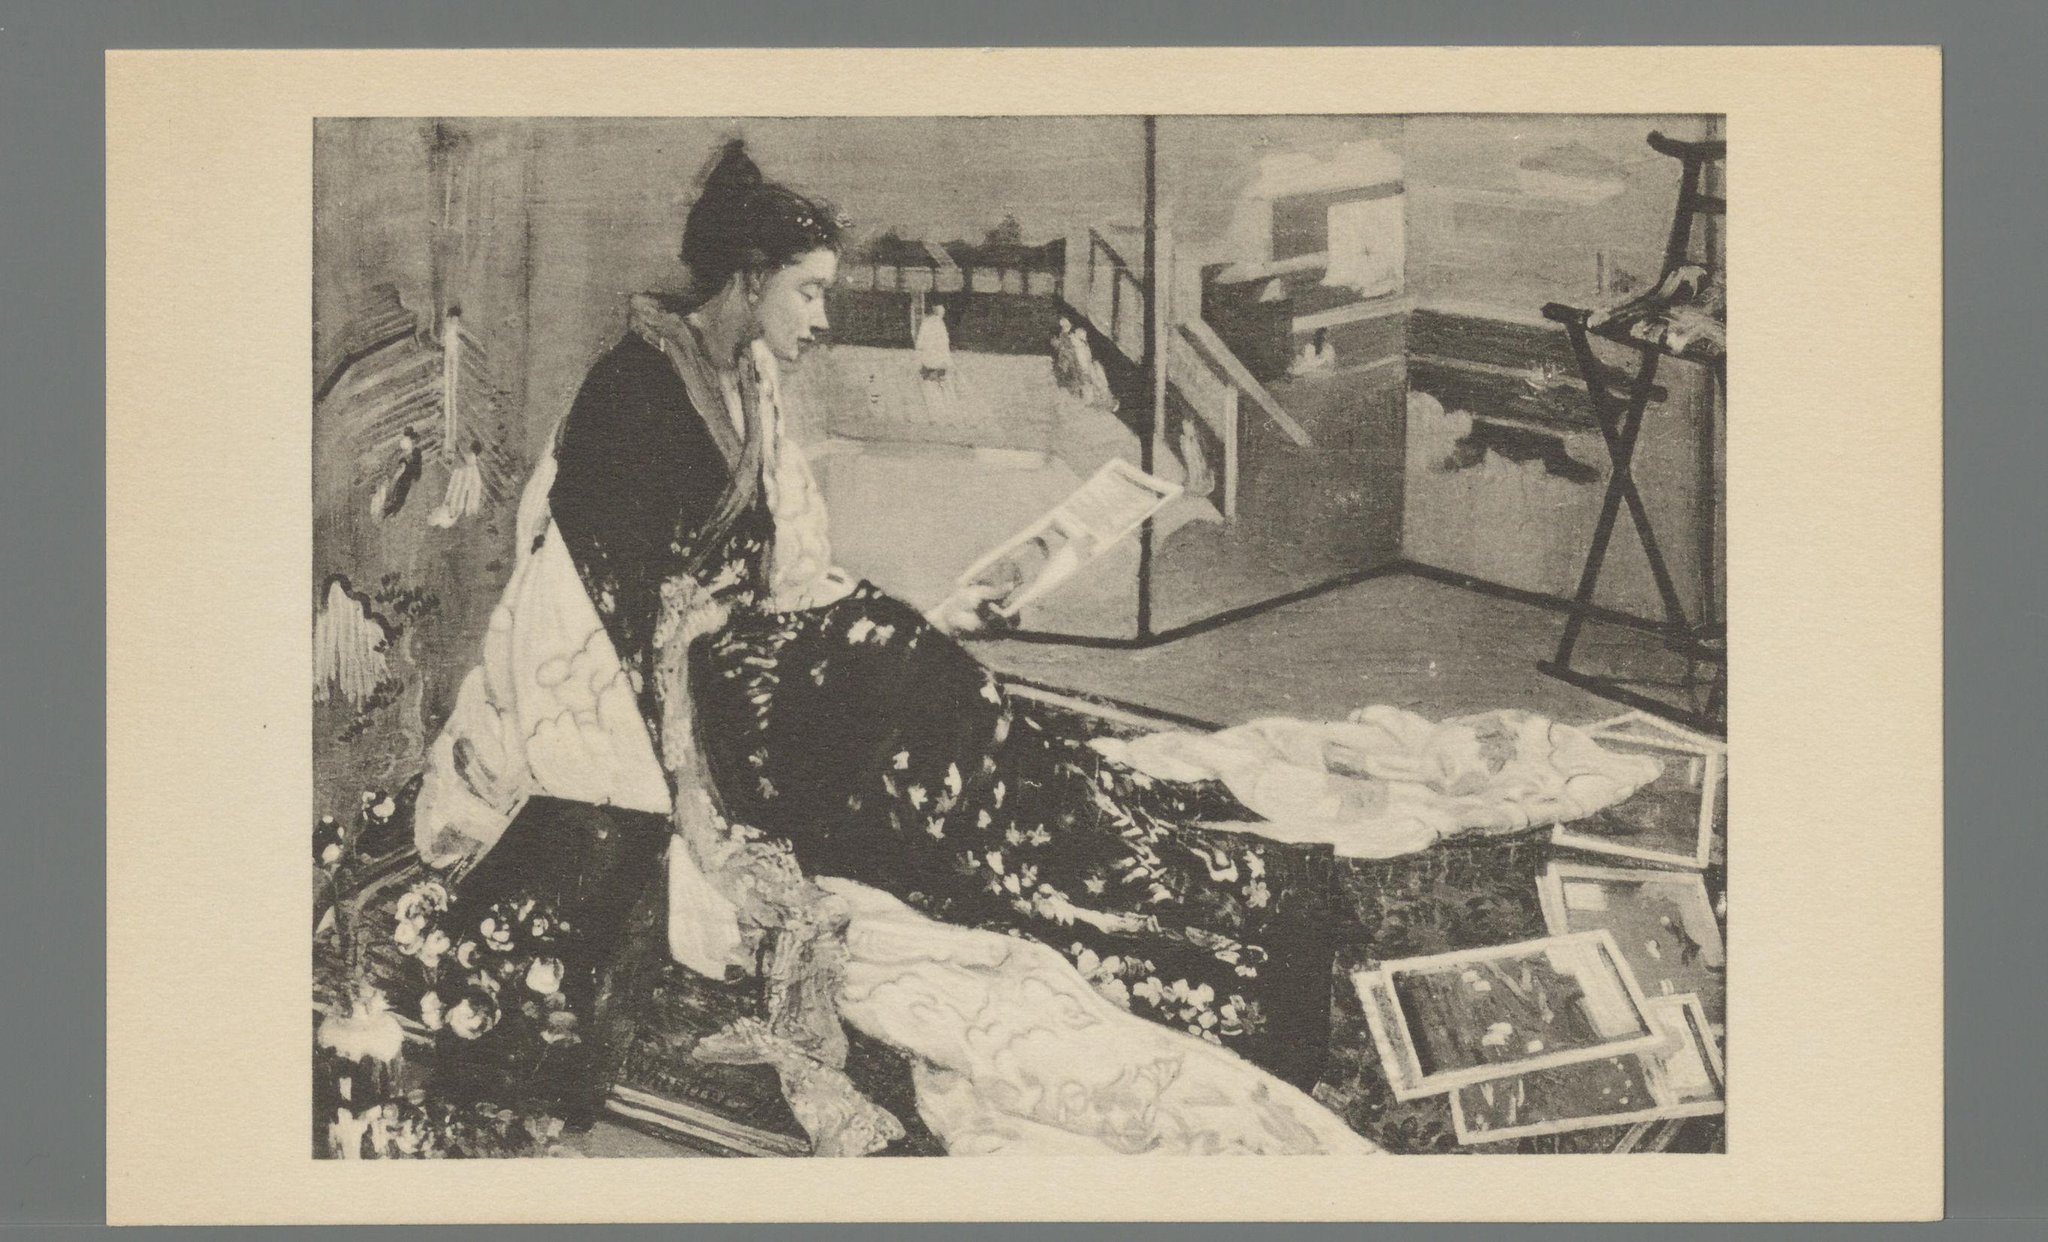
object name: reproduction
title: Caprice in purple and gold, No. 2: The Golden Screen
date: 1920-1950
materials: cardboard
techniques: photograph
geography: washington d.c.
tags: adult woman (+ sitting), painting (including book-illumination, miniature-painting), screen, folding screen